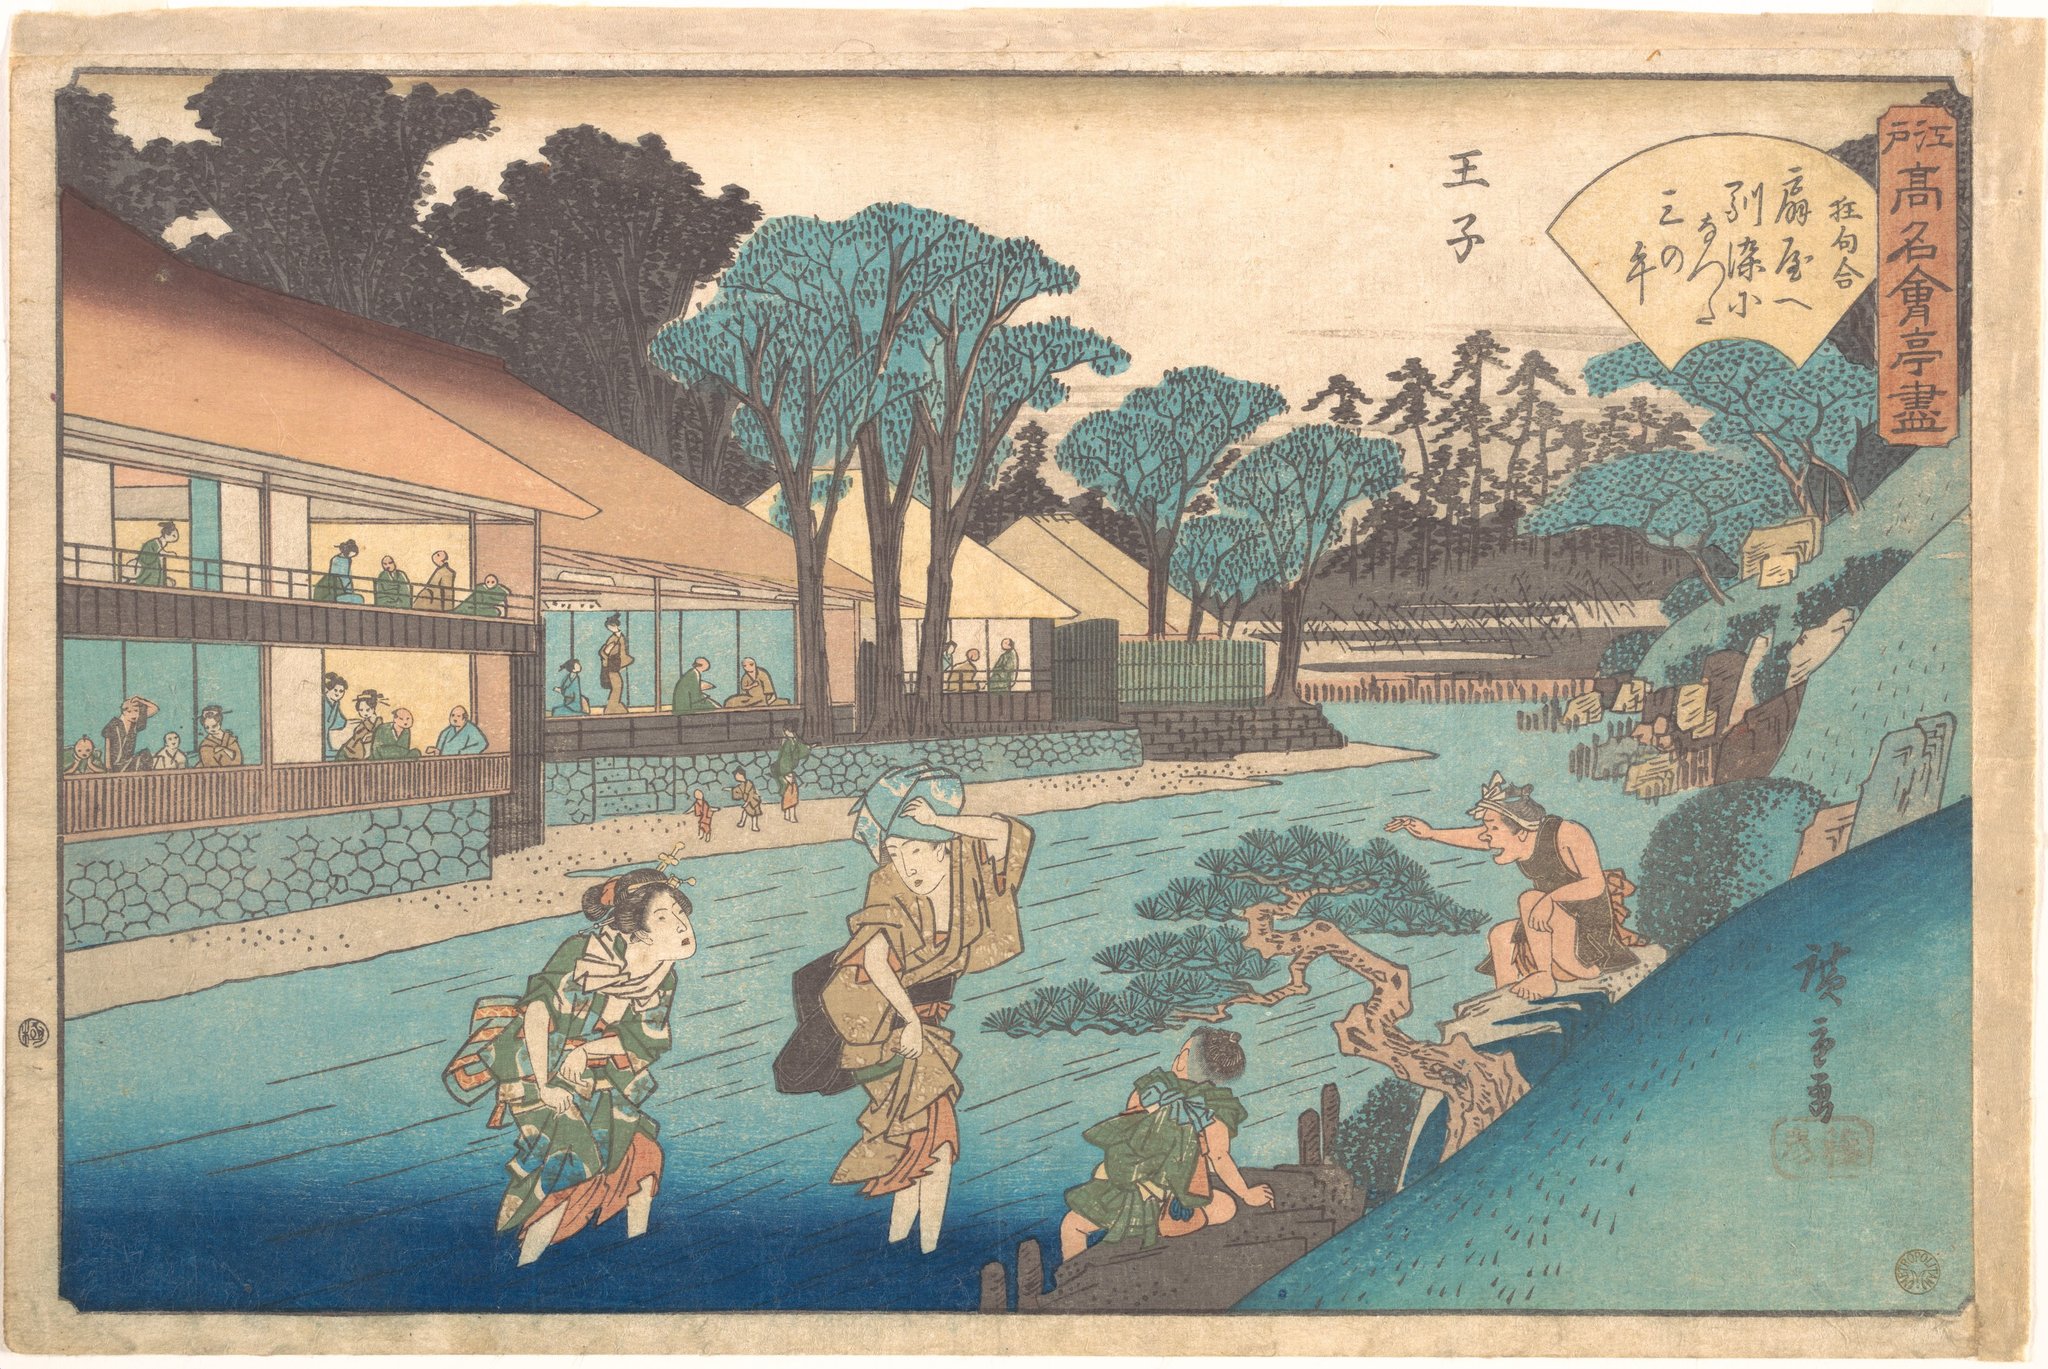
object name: print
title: The Ōgiya at Ōji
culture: japanese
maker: utagawa hiroshige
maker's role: artist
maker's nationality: japanese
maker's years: 1797-1858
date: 1835-1842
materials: ink, paper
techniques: woodblock print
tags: buildings,women,streams